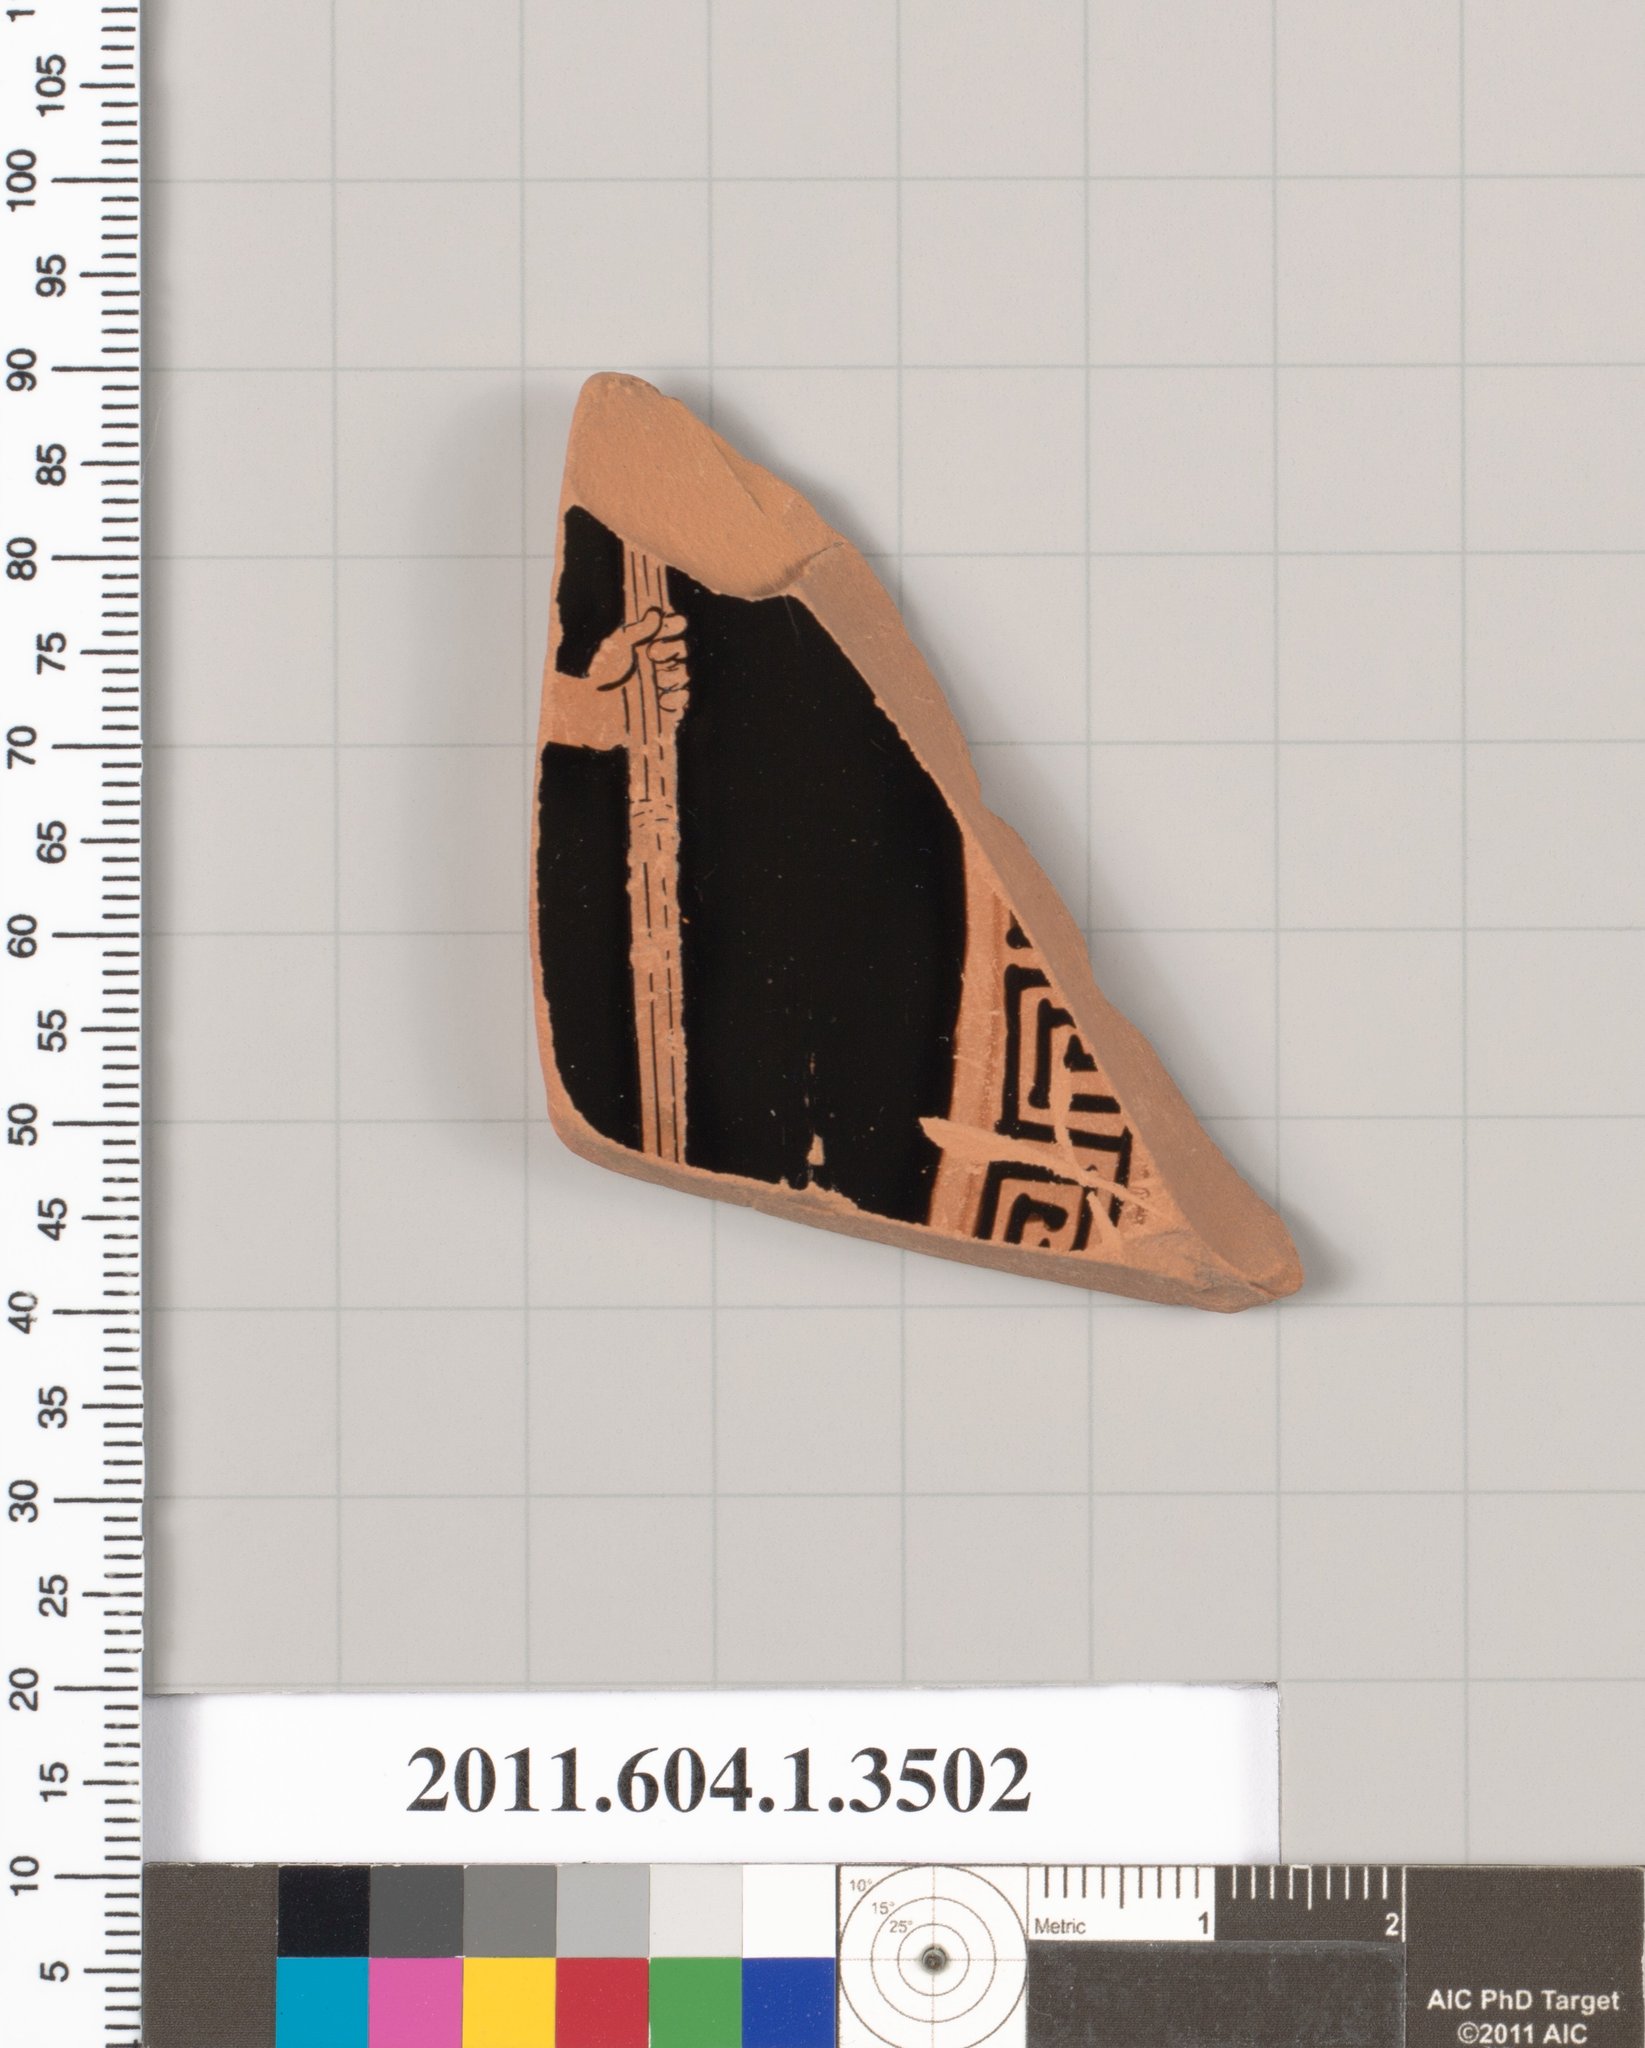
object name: kylix fragment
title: Terracotta fragment of a kylix (drinking cup)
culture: greek, attic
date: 500-476 BCE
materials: terracotta